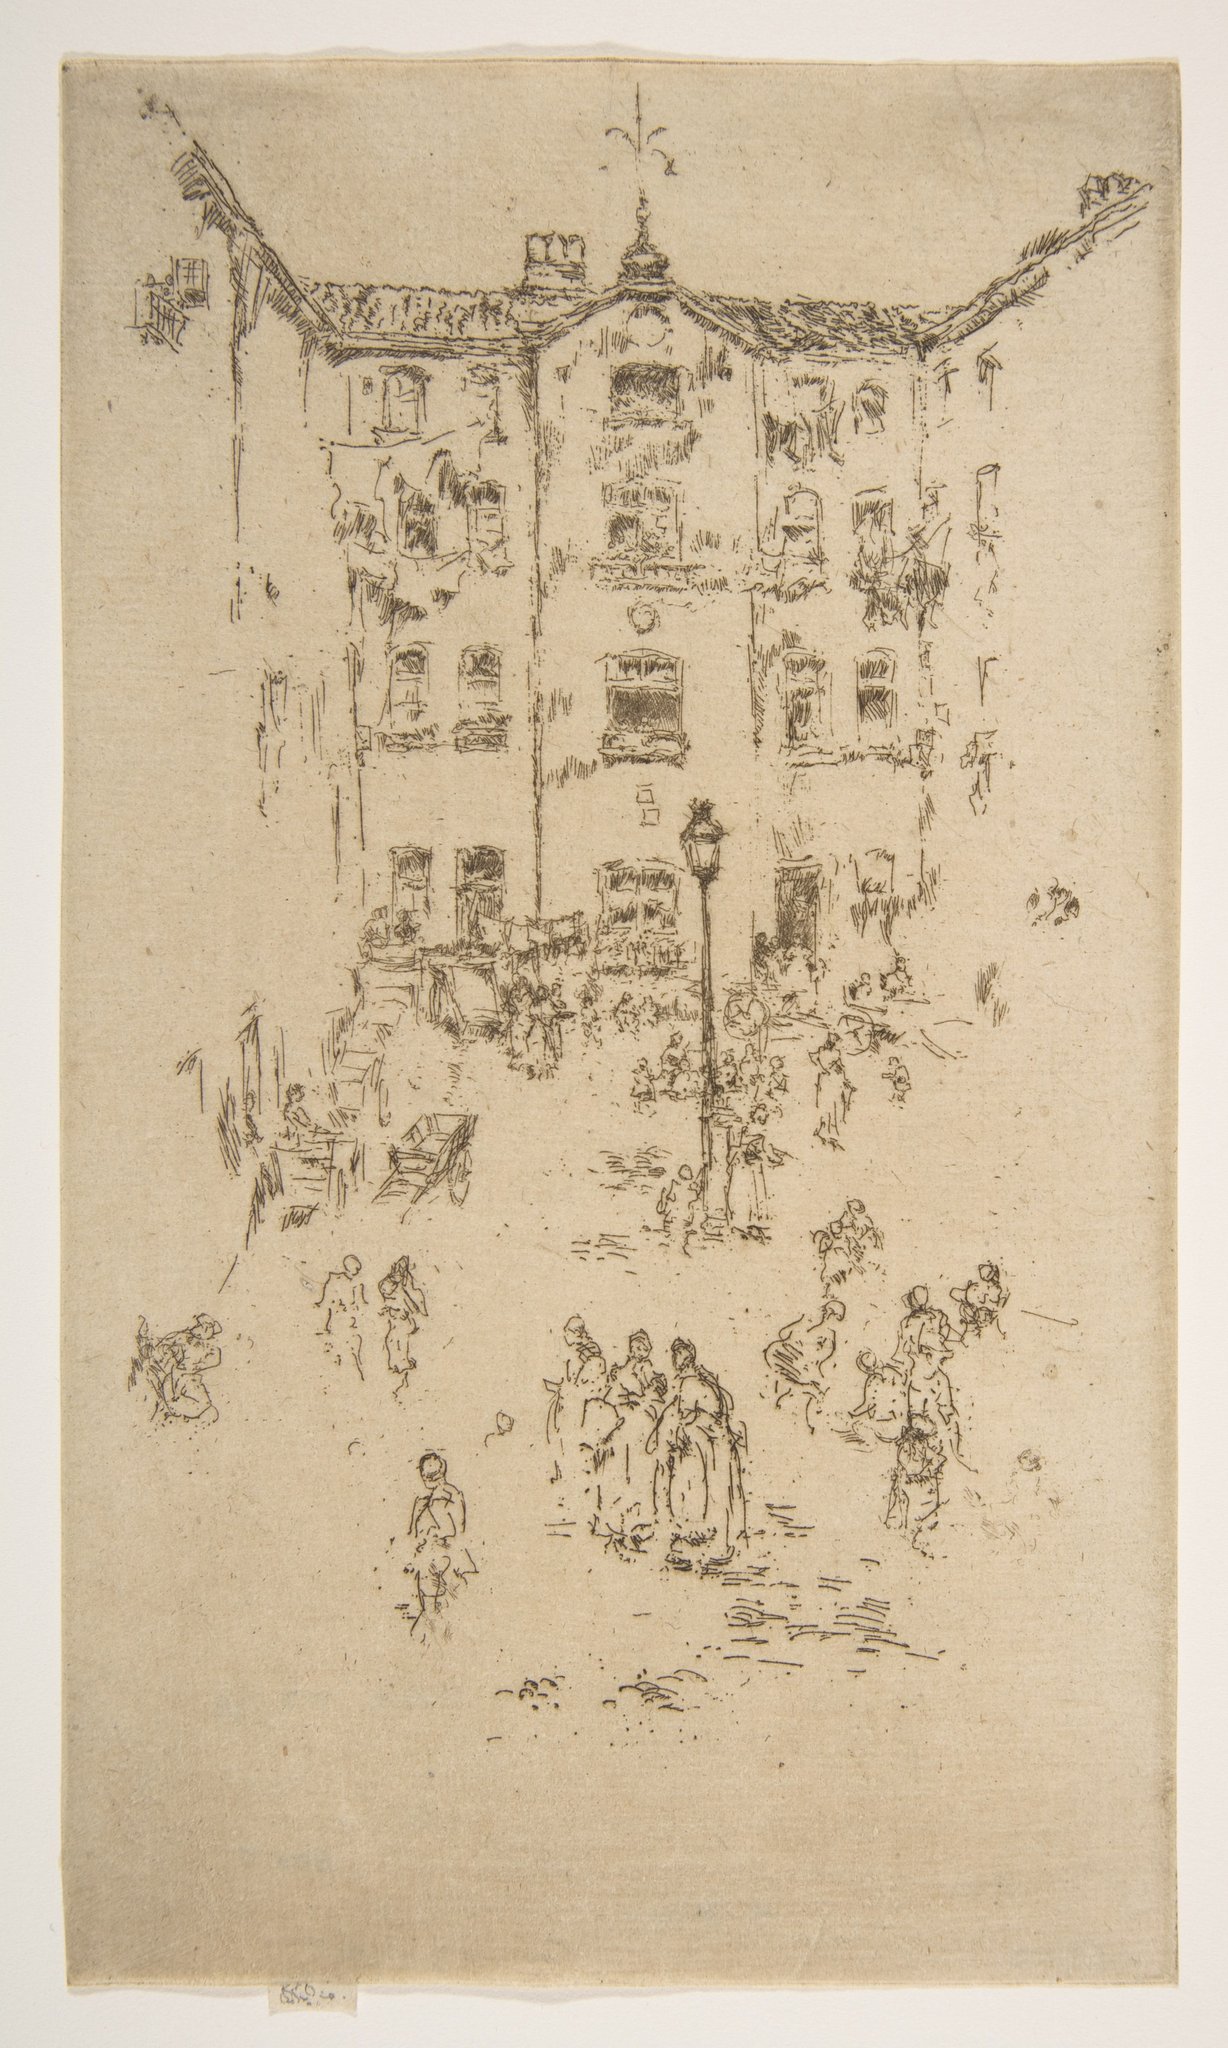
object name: print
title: Courtyard, Brussels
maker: james mcneill whistler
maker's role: artist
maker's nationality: american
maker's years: 1834-1903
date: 1887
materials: ink, paper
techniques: etching, printing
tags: human figures,buildings,courtyards